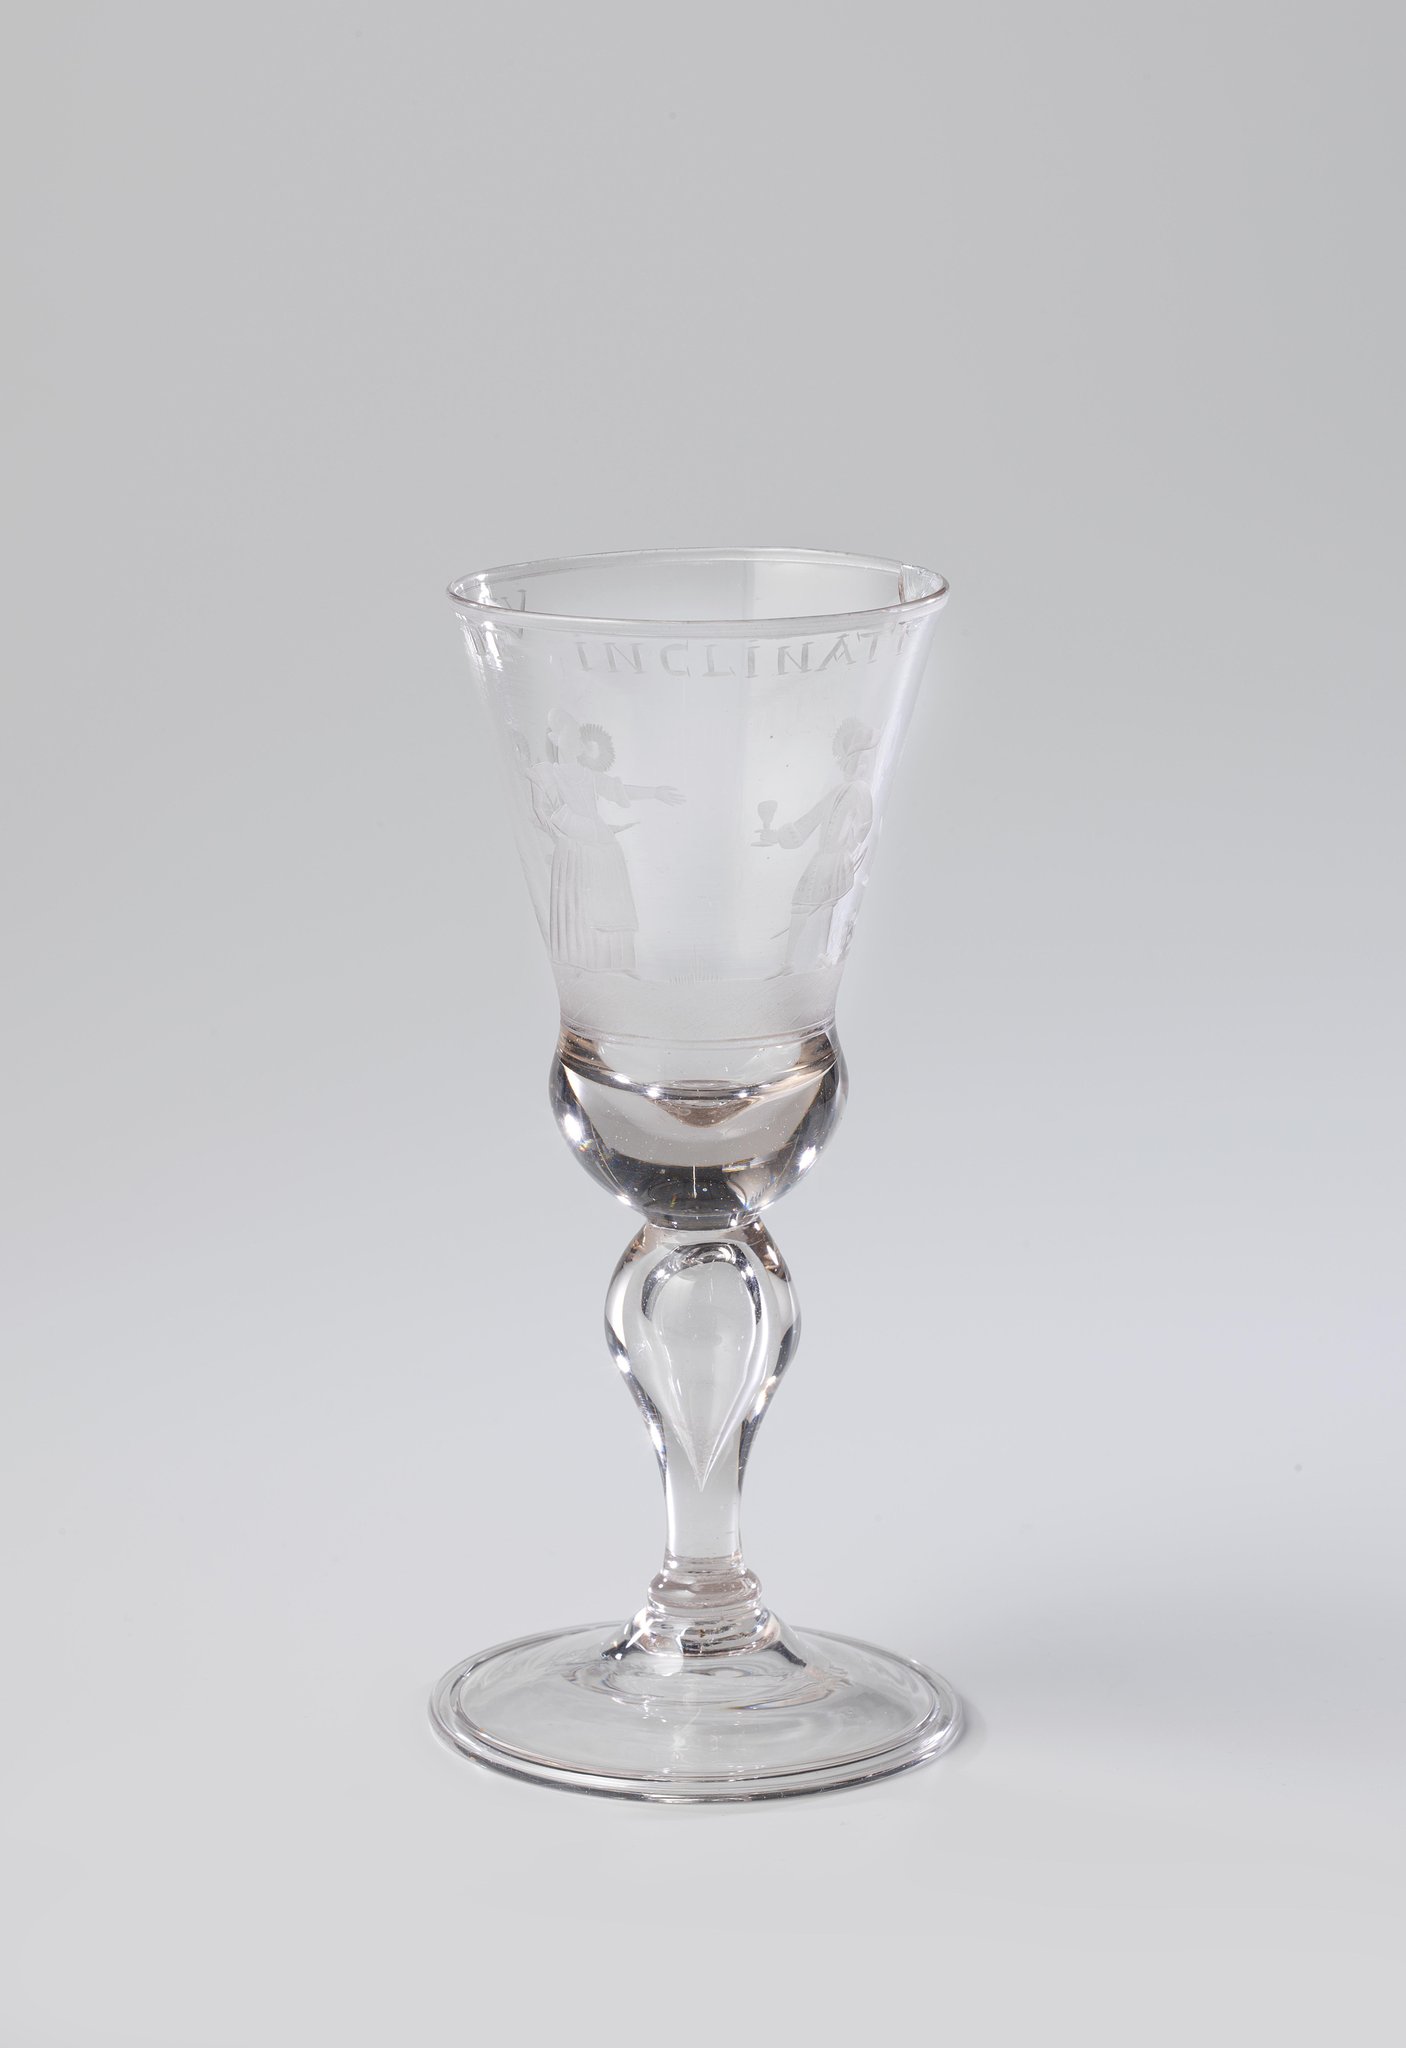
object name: goblet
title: Kelkglas met een vrouw en een man met geheven glas en het opschrift: VIVAT DE INCLINATI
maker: Anonymous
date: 1725-1750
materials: glass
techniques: glassblowing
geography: northern netherlands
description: Kelkglas van helder, kleurloos glas met voorstelling van een vrouw en een man met geheven glas en het opschrift: VIVAT DE INCLINATI.